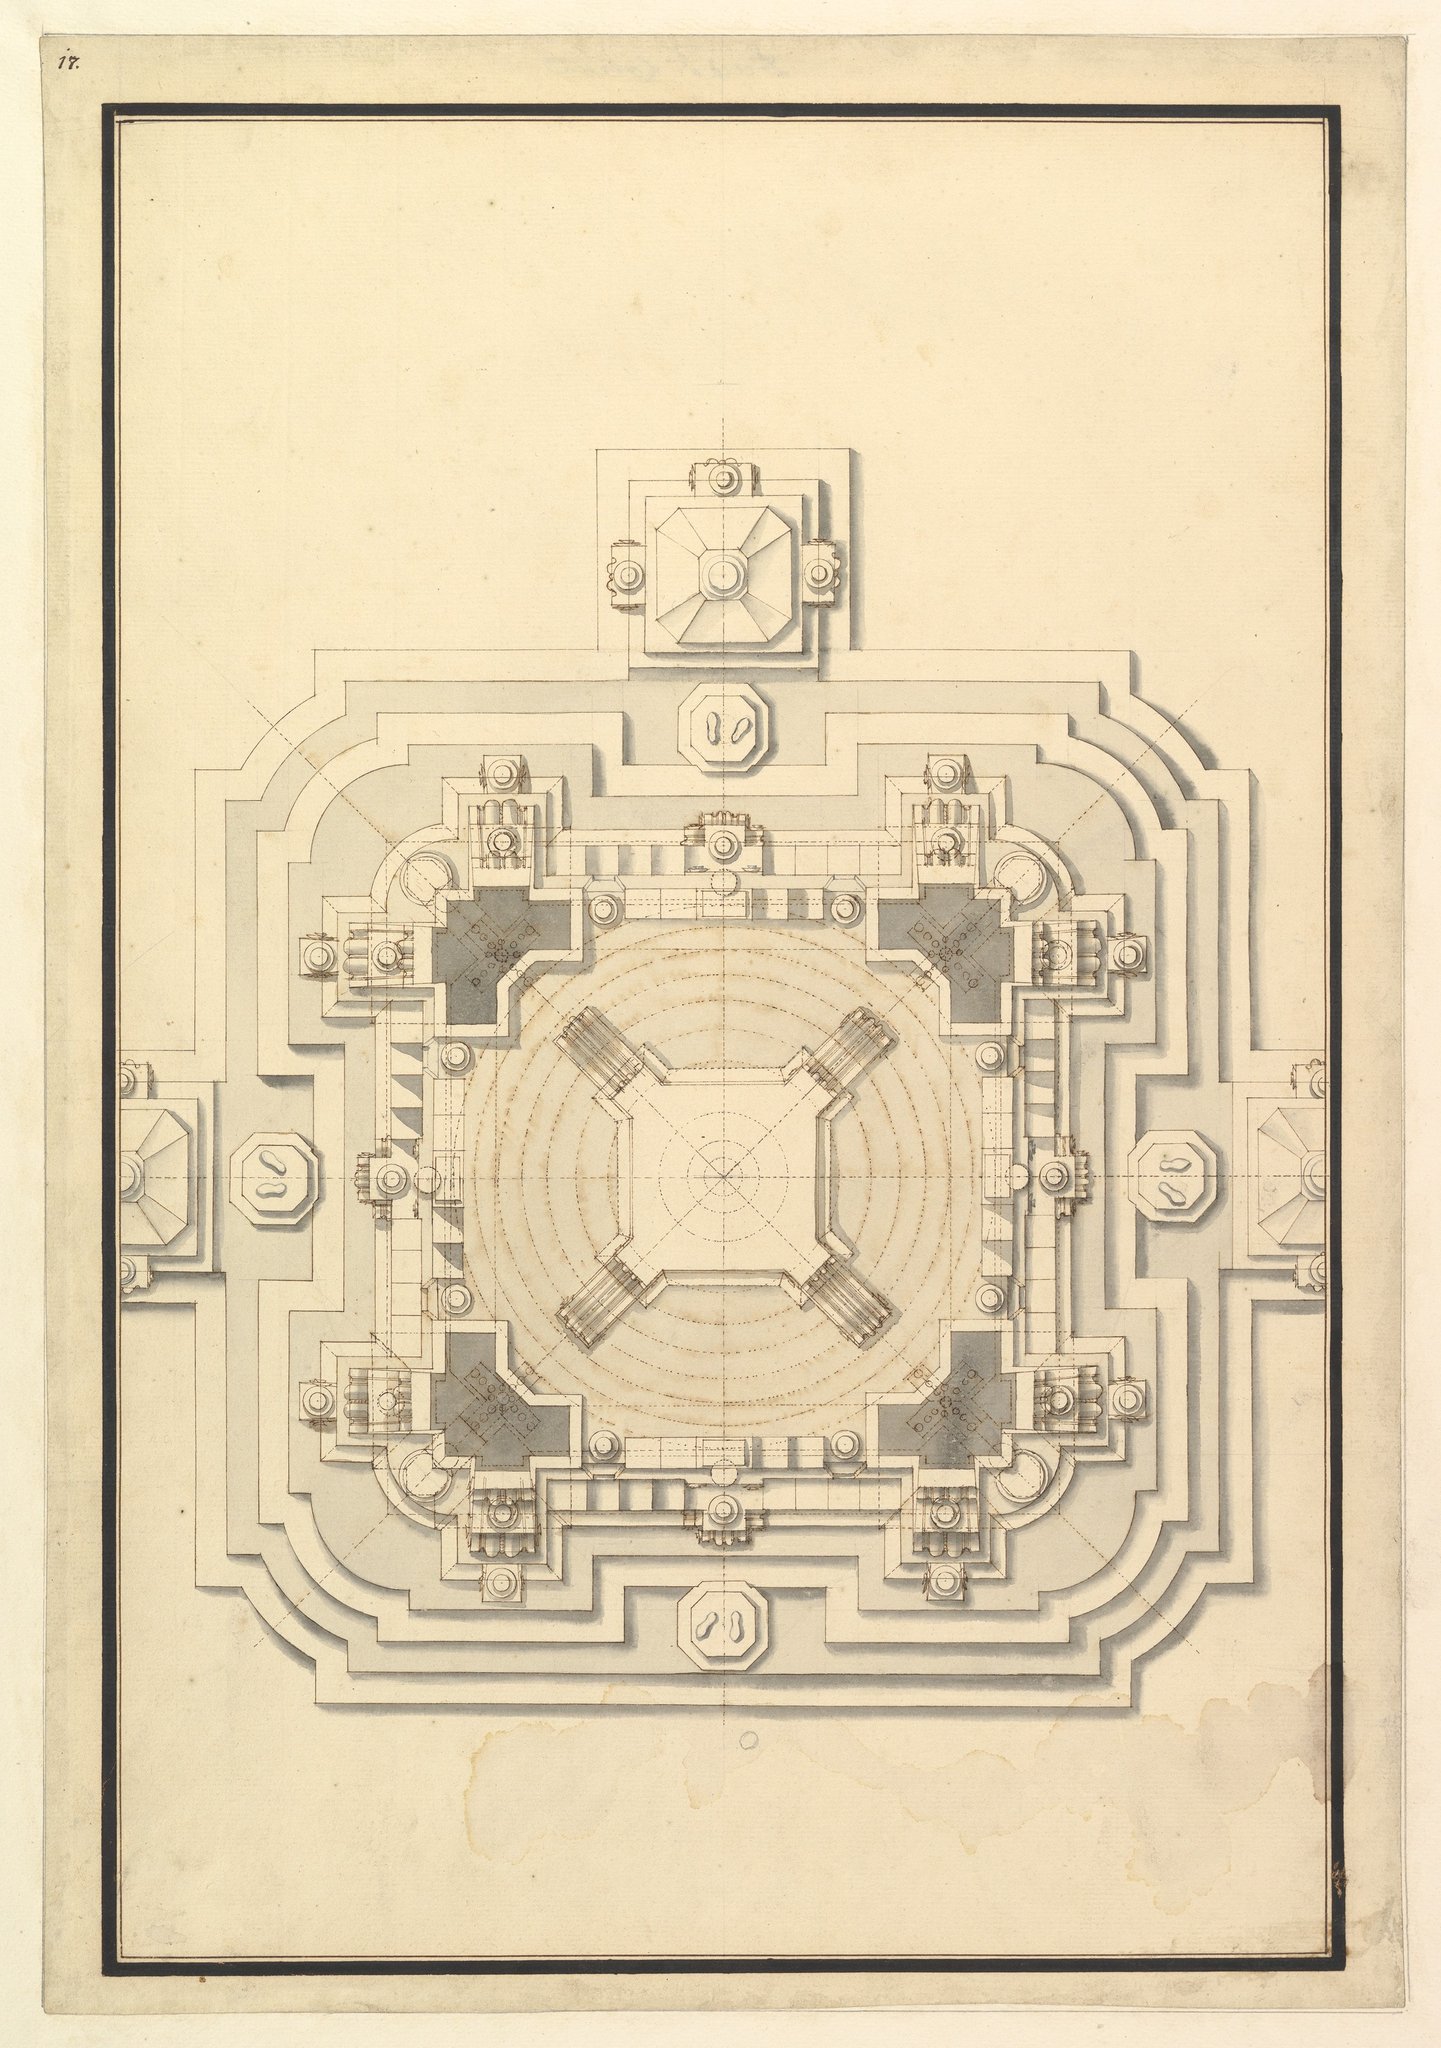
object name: drawing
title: Ground Plan for a Catafalque for Leopold, Duke of Lorraine (d. 1729)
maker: giuseppe galli bibiena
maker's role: artist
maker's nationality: italian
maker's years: 1696-1756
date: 1729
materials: ink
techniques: pen, wash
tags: architecture